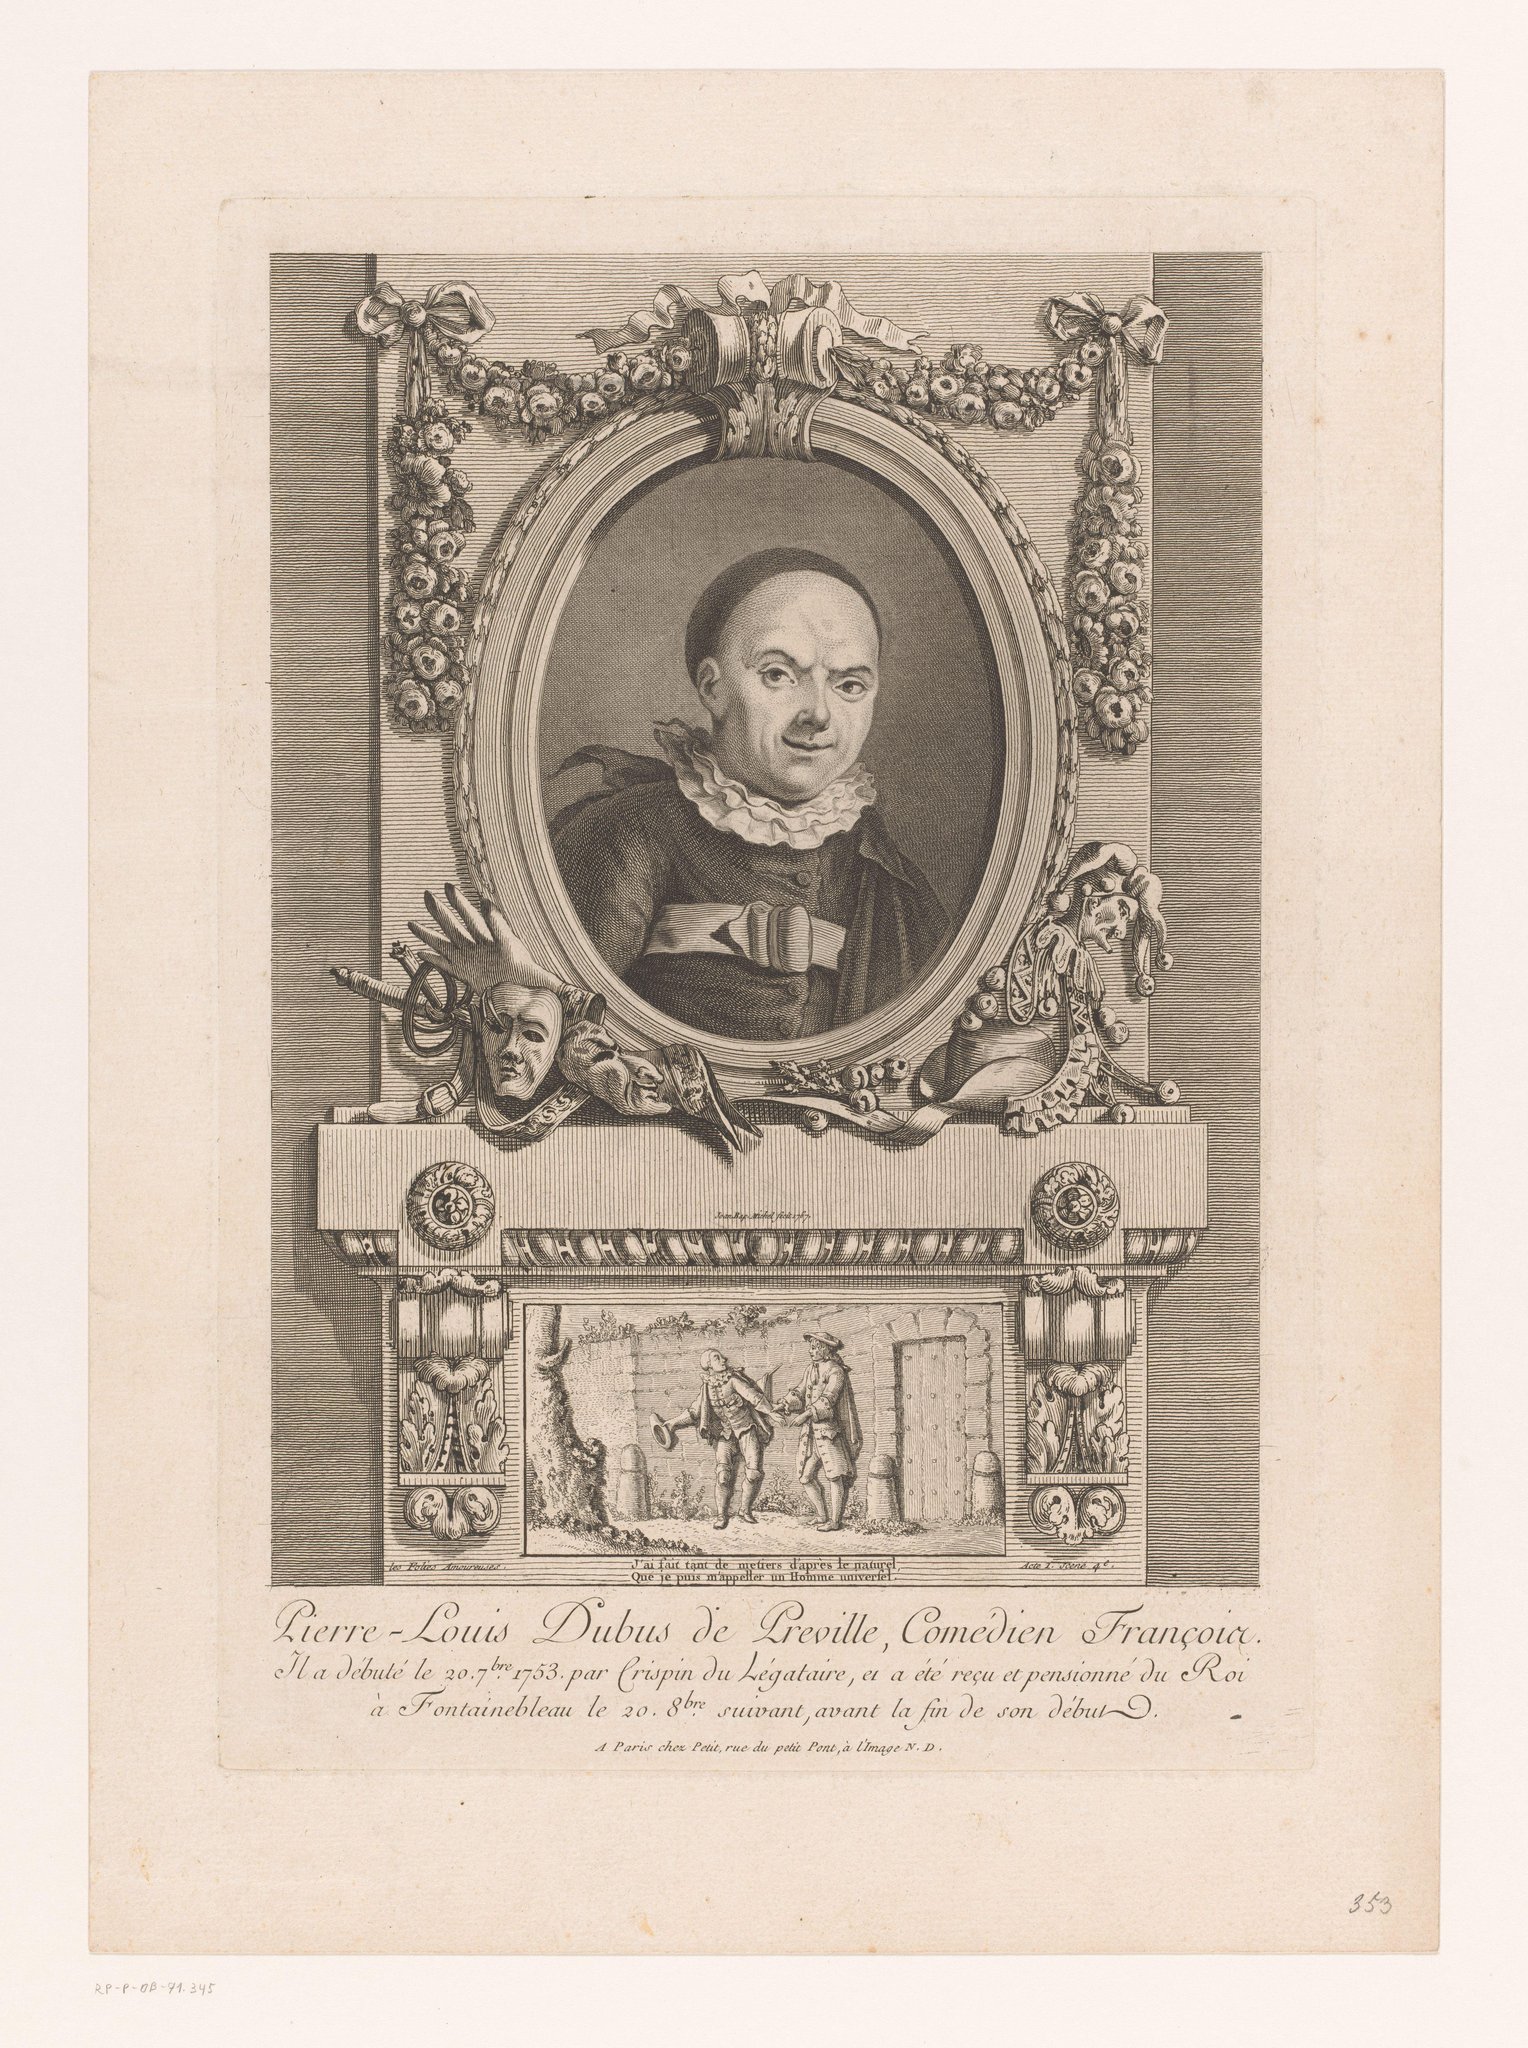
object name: print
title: Portret van Pierre-Louis Dubus de Preville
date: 1767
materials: paper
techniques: engraving, etching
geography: paris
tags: historical persons, portrait of actor, actress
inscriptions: collector's mark: Lugt 2228